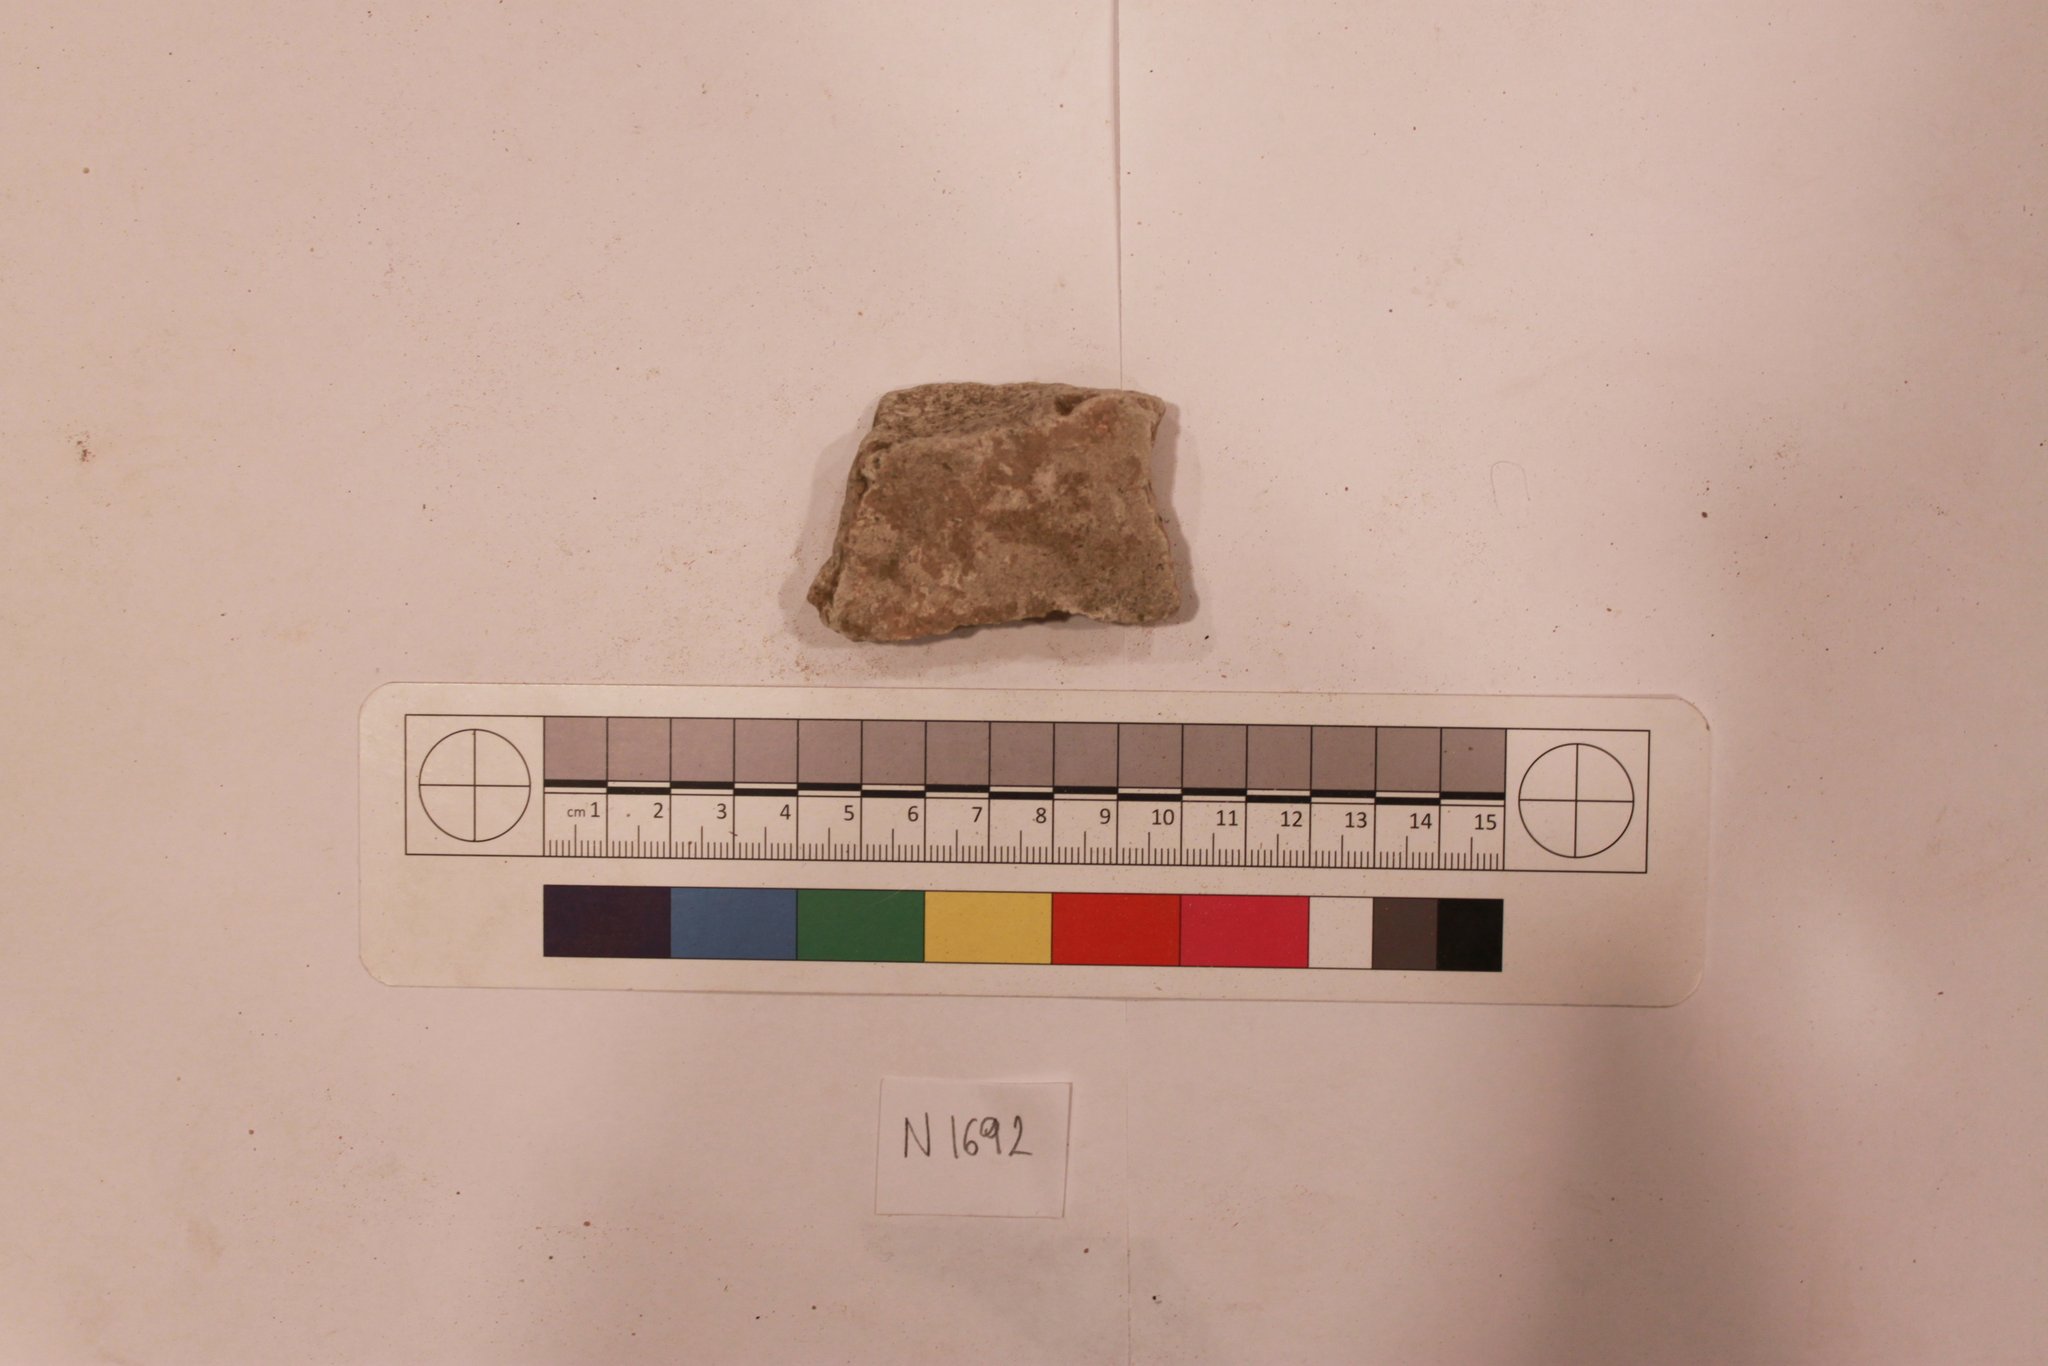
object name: fragment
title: Stucco Fragment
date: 701-1200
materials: plaster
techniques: carving, painting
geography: iran